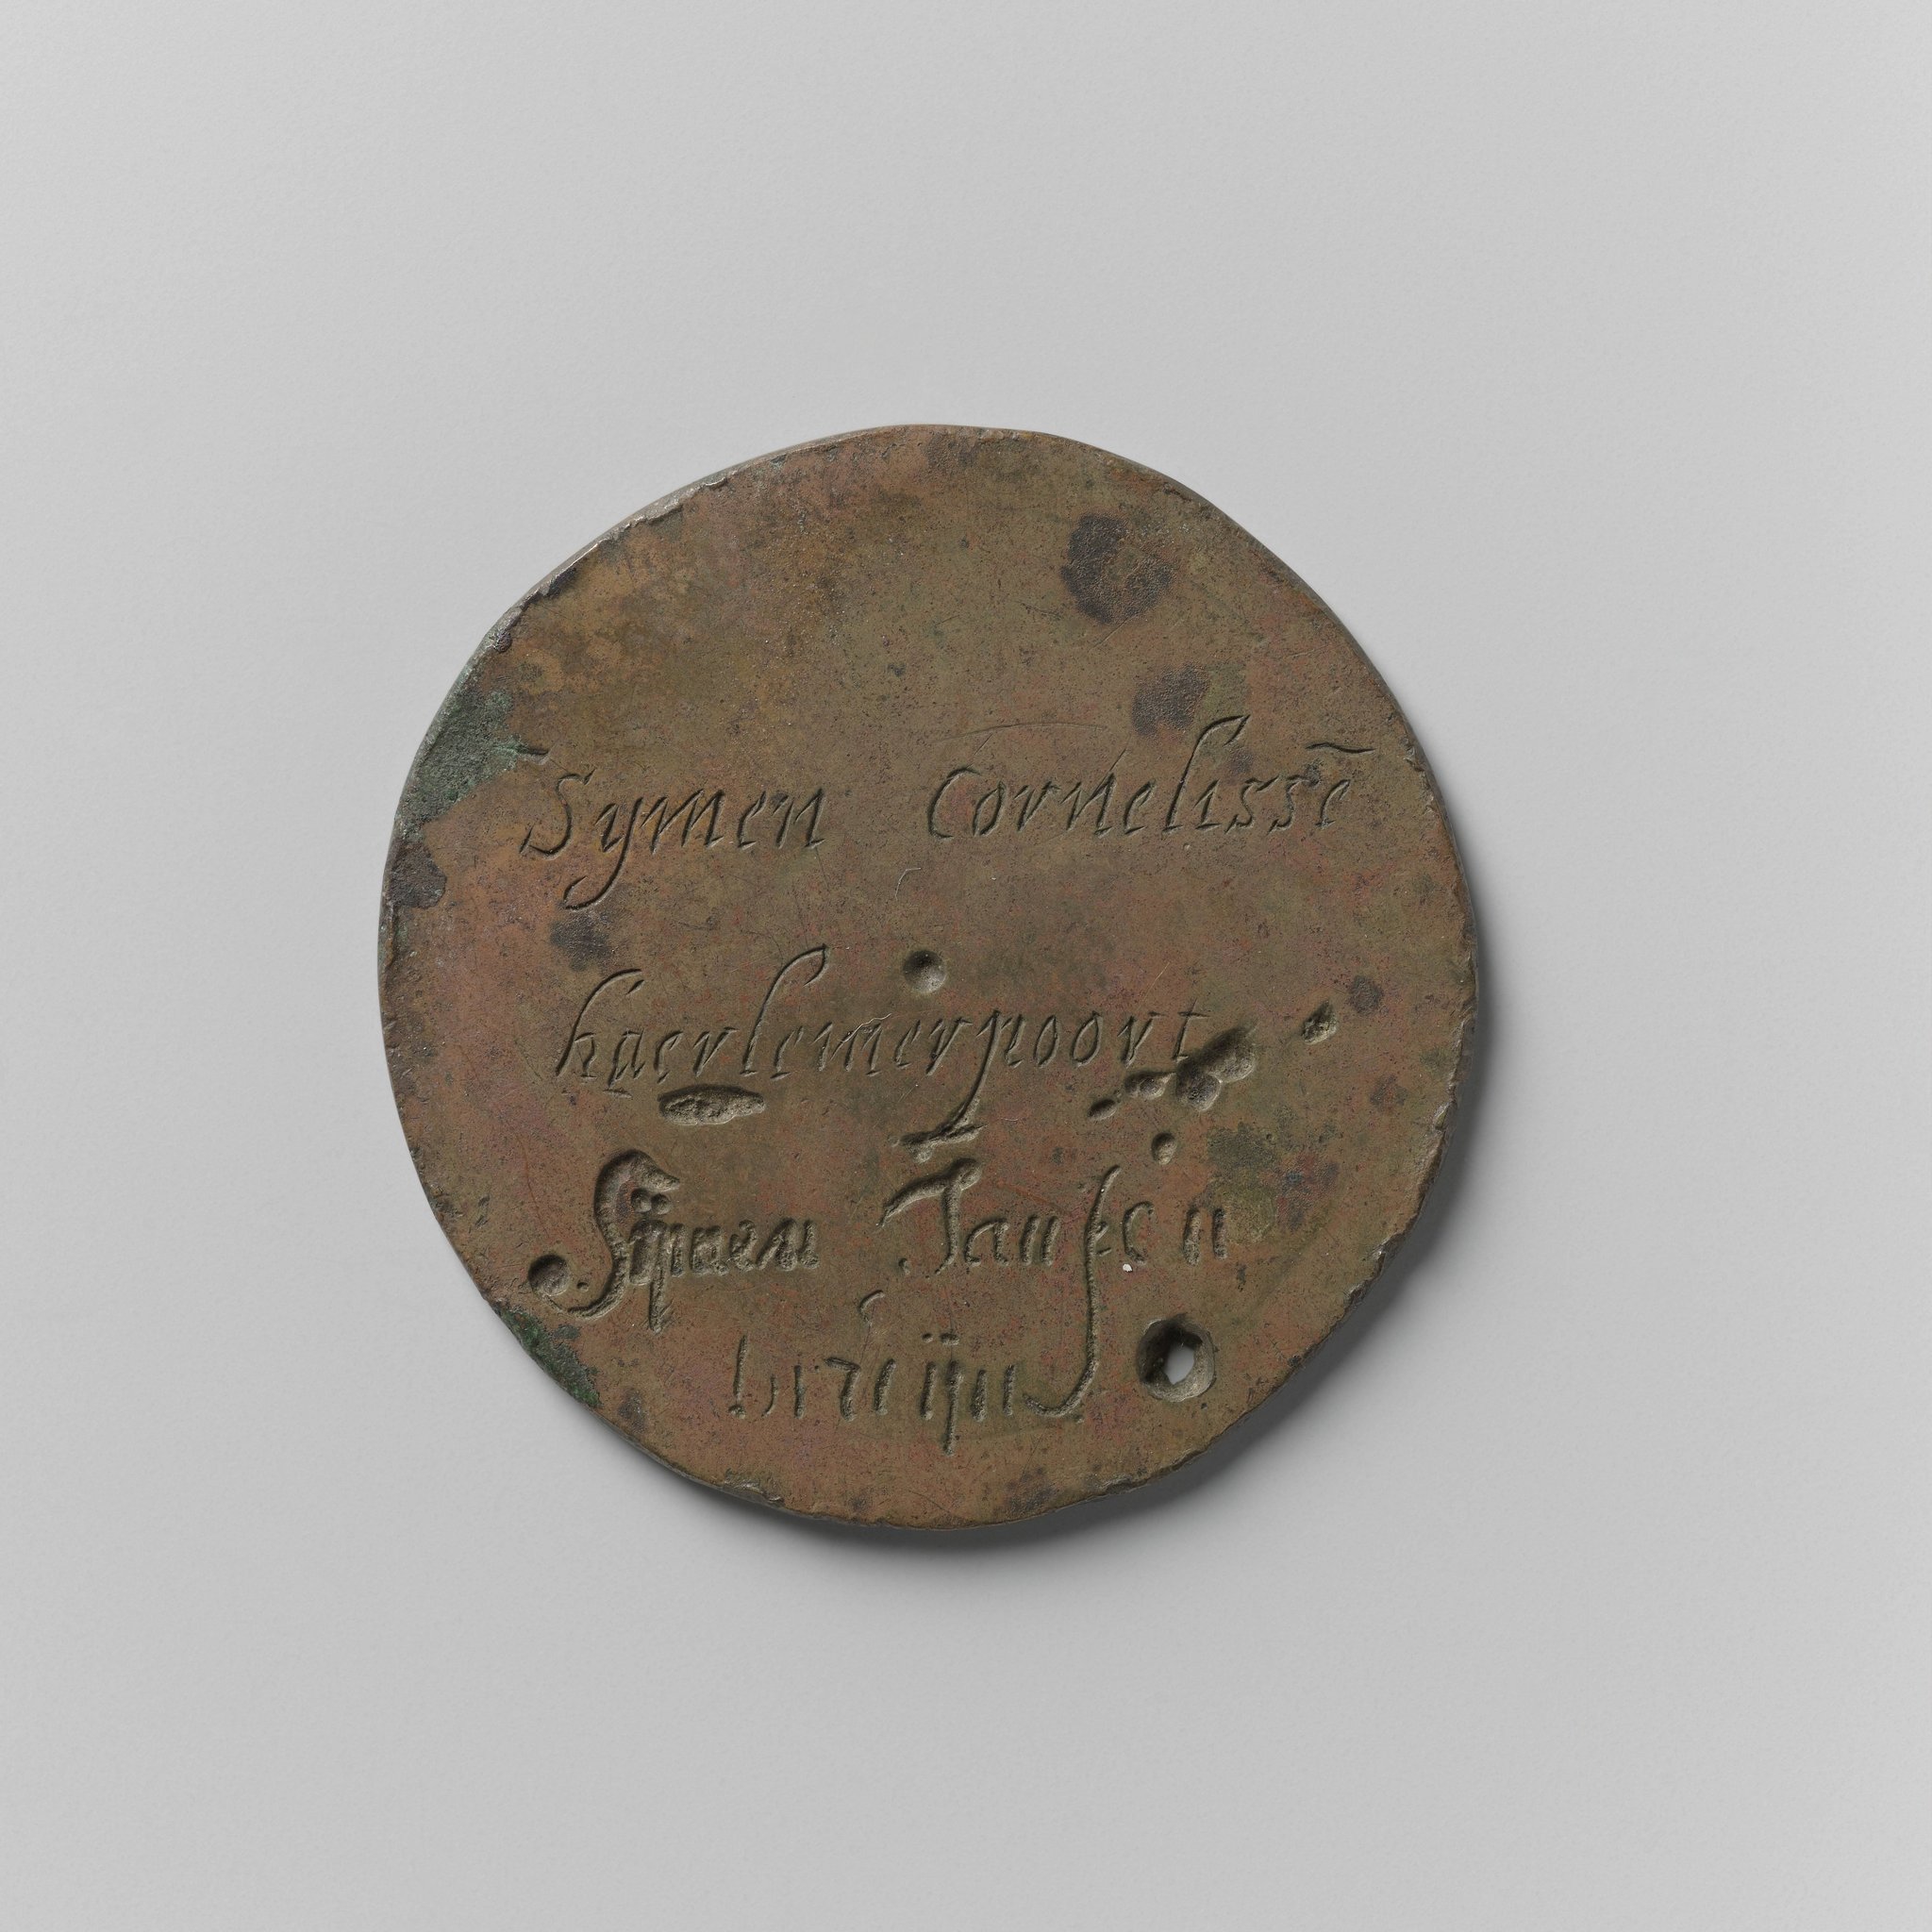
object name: medal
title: Scheepstimmerliedengilde van Amsterdam, gildepenning van Symen Cornelisse van de Haarlemmerpoort en van Symen Jansen Bruyn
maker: Anonymous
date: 1600-1800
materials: brass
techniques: engraving, striking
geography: amsterdam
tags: amsterdam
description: Messing penning met gat erin. Voorzijde: naar rechts varende, onopgetuigde driemaster binnen dubbele karns. Keerzijde: opschrift